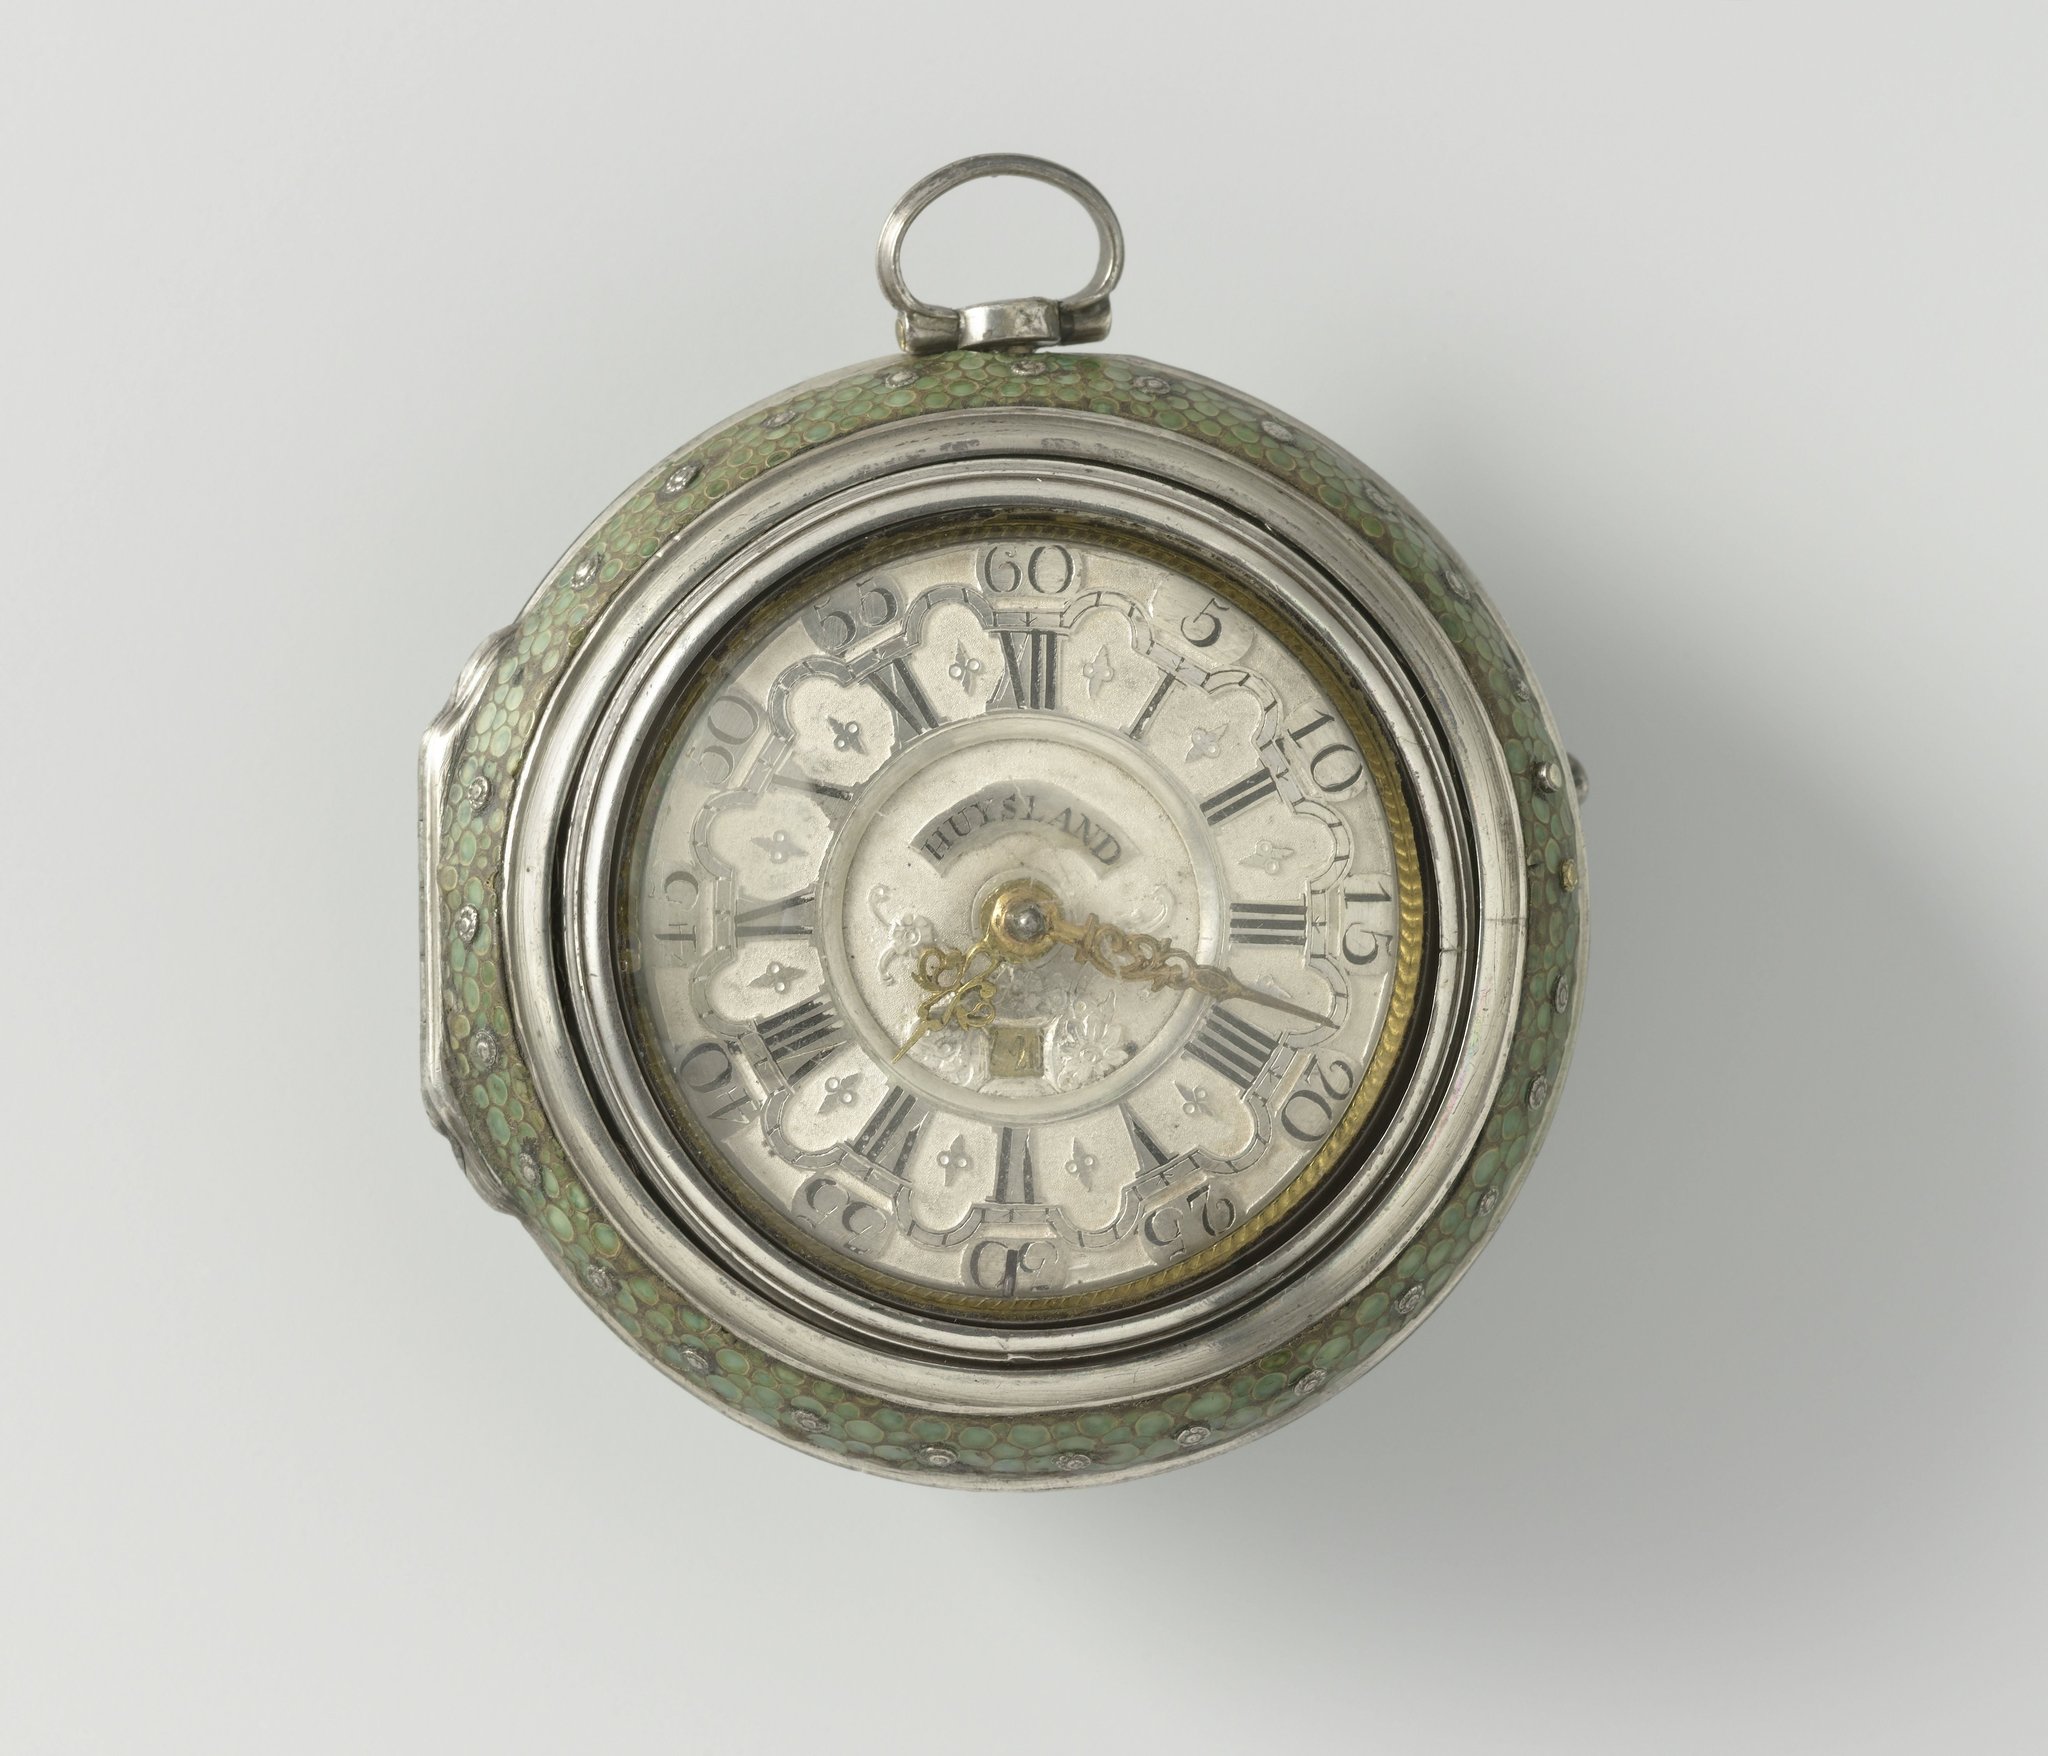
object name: pocket watch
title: Zakhorloge met gedreven voorstelling van een walvisvaarder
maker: hermanus huyslandt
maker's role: clockmaker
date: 1775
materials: silver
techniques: repoussé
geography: amsterdam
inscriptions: signature: ‘Huysland’, signature: ‘Herman. s. Huysland, Amsterdam’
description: Zilveren horloge met zilveren wijzerplaat, gemerkt: Huysland. Het werk van binnen gemerkt: Hermans Huysland, Amsterdam. het geheel besloten in een gedreven zilveren kast, waarop de voorstelling van een walvisvaarder met drie sloepen een walvis harpoenerend gevat in een rand van Lodewijk XV ornament met zeemonsters. De buitenkast is van zilver met groen roggenvel overtrokken. Glazen van de buitenkast ontbreken.